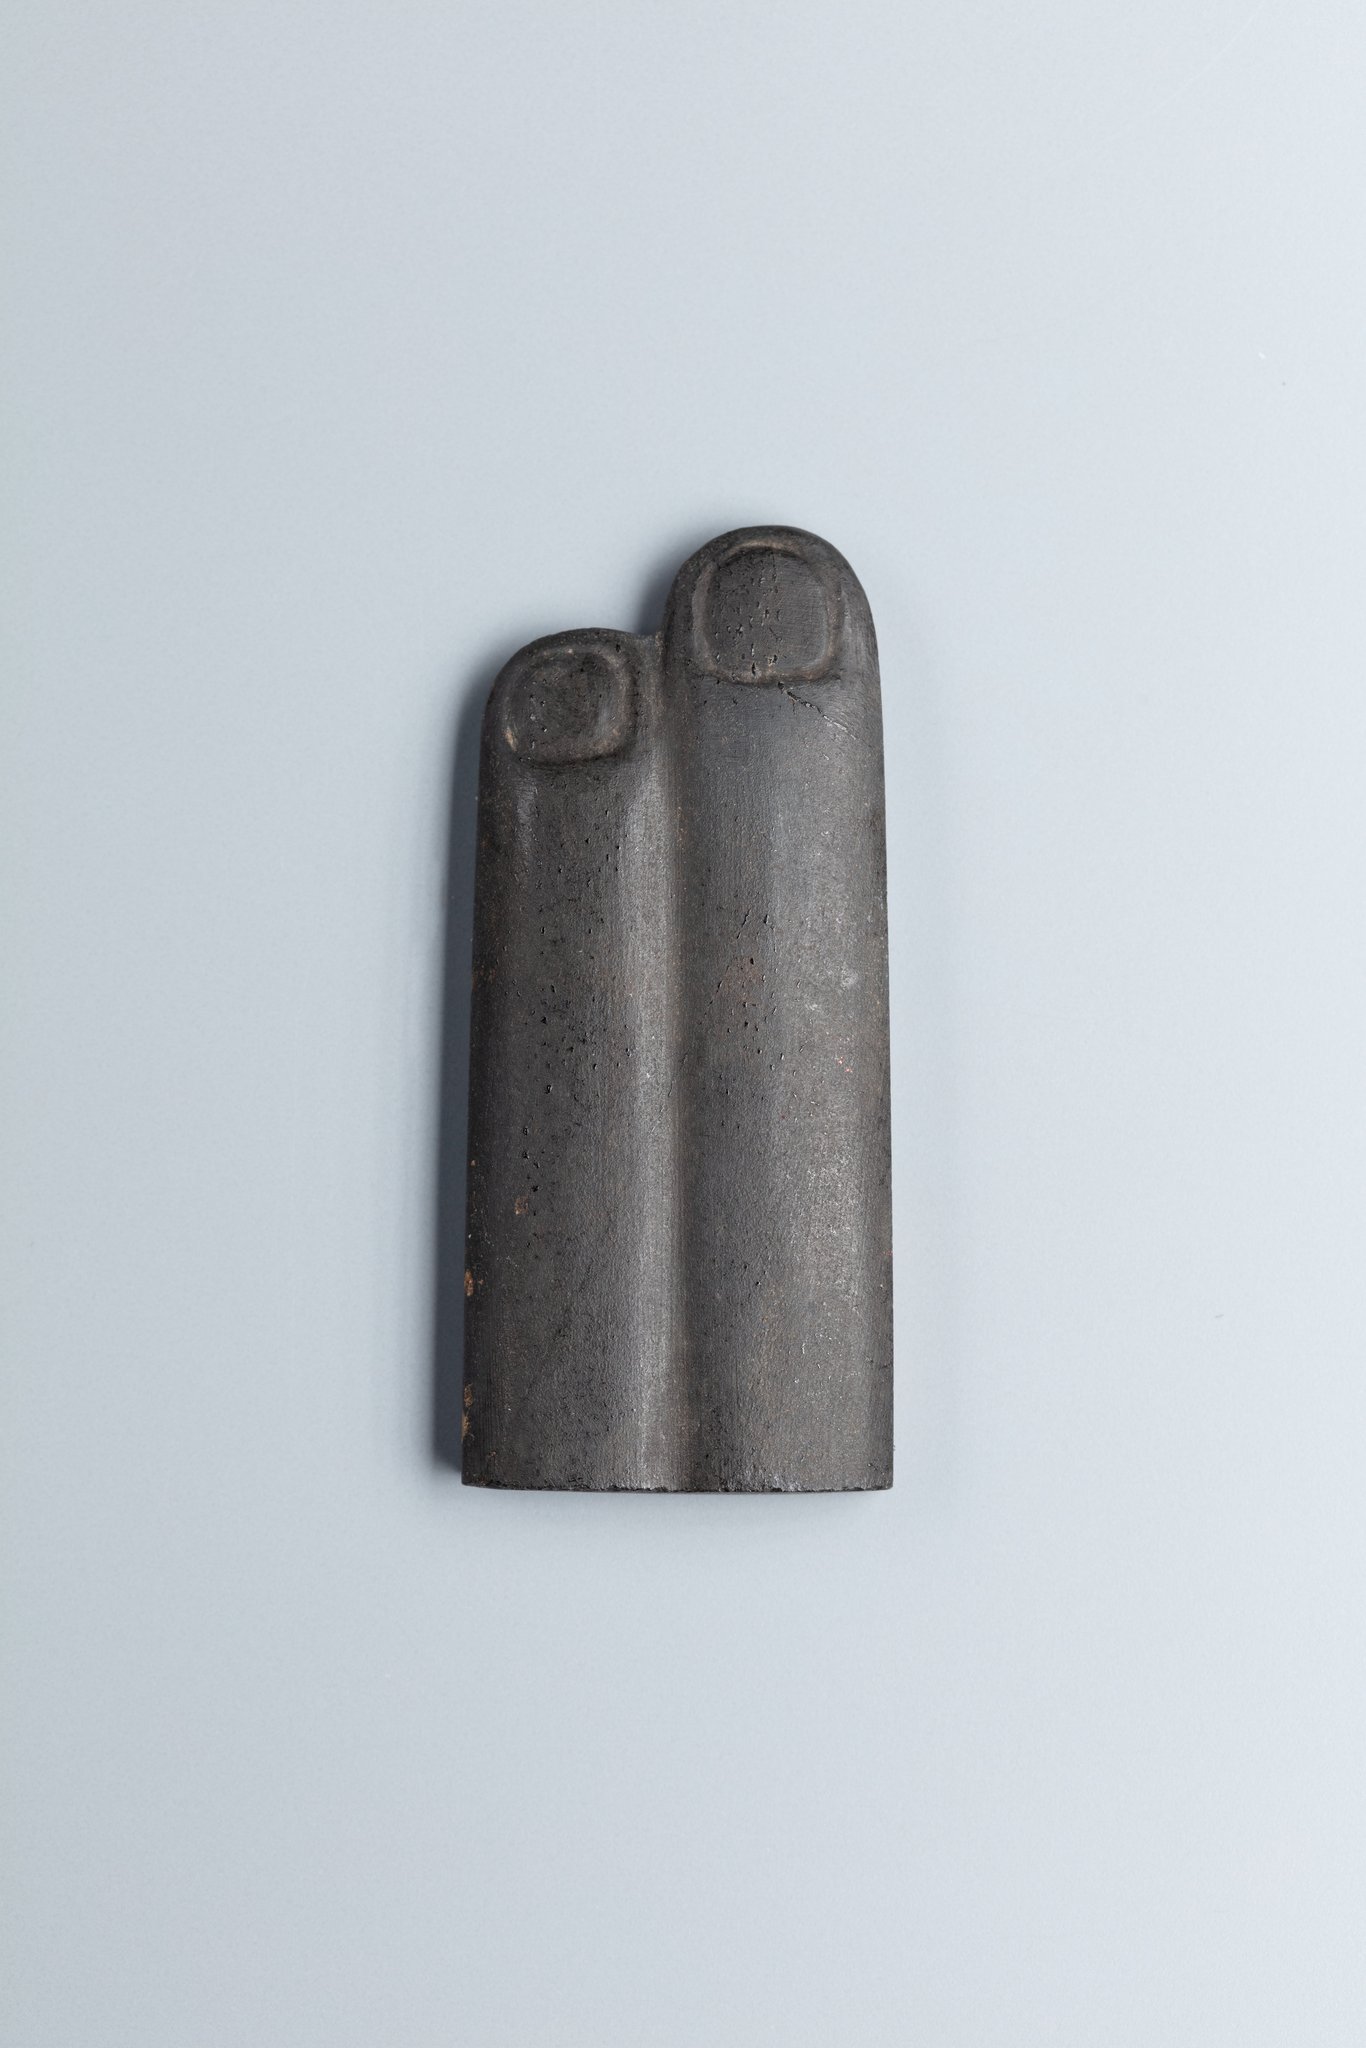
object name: amulet, two finger amulet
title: Two-finger amulet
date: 664-332 BCE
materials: glass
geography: egypt